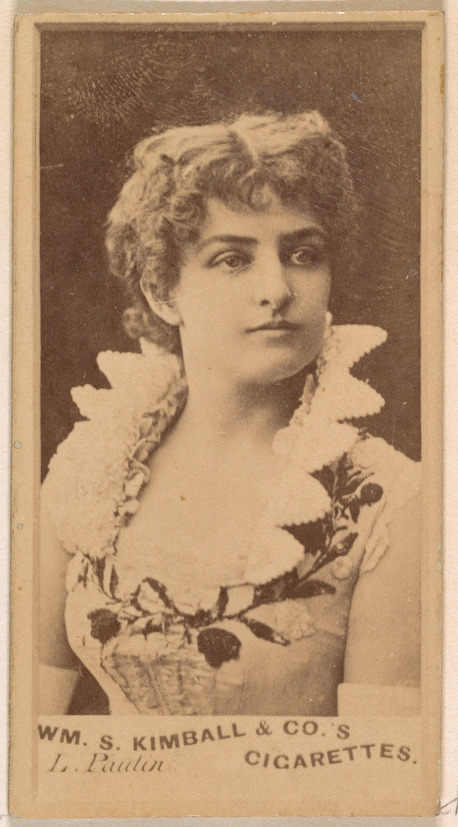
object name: photograph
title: Miss Paulin, from the Actresses series (N203) issued by Wm. S. Kimball & Co.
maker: william s. kimball & company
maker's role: publisher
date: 1889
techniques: color lithograph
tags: portraits,women,actresses